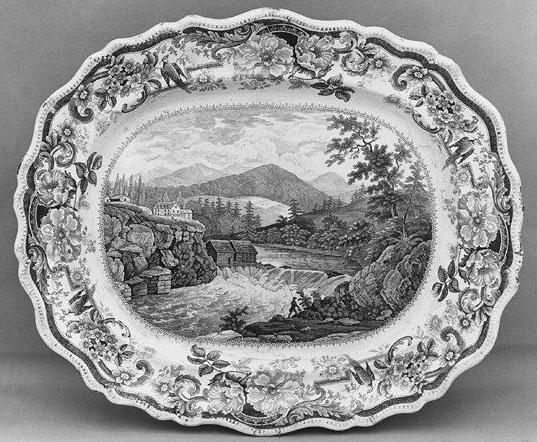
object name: platter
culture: british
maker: james and ralph clews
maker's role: maker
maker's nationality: british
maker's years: 1813-1836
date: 1821-1834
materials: earthenware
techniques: transfer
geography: england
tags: flowers,landscapes